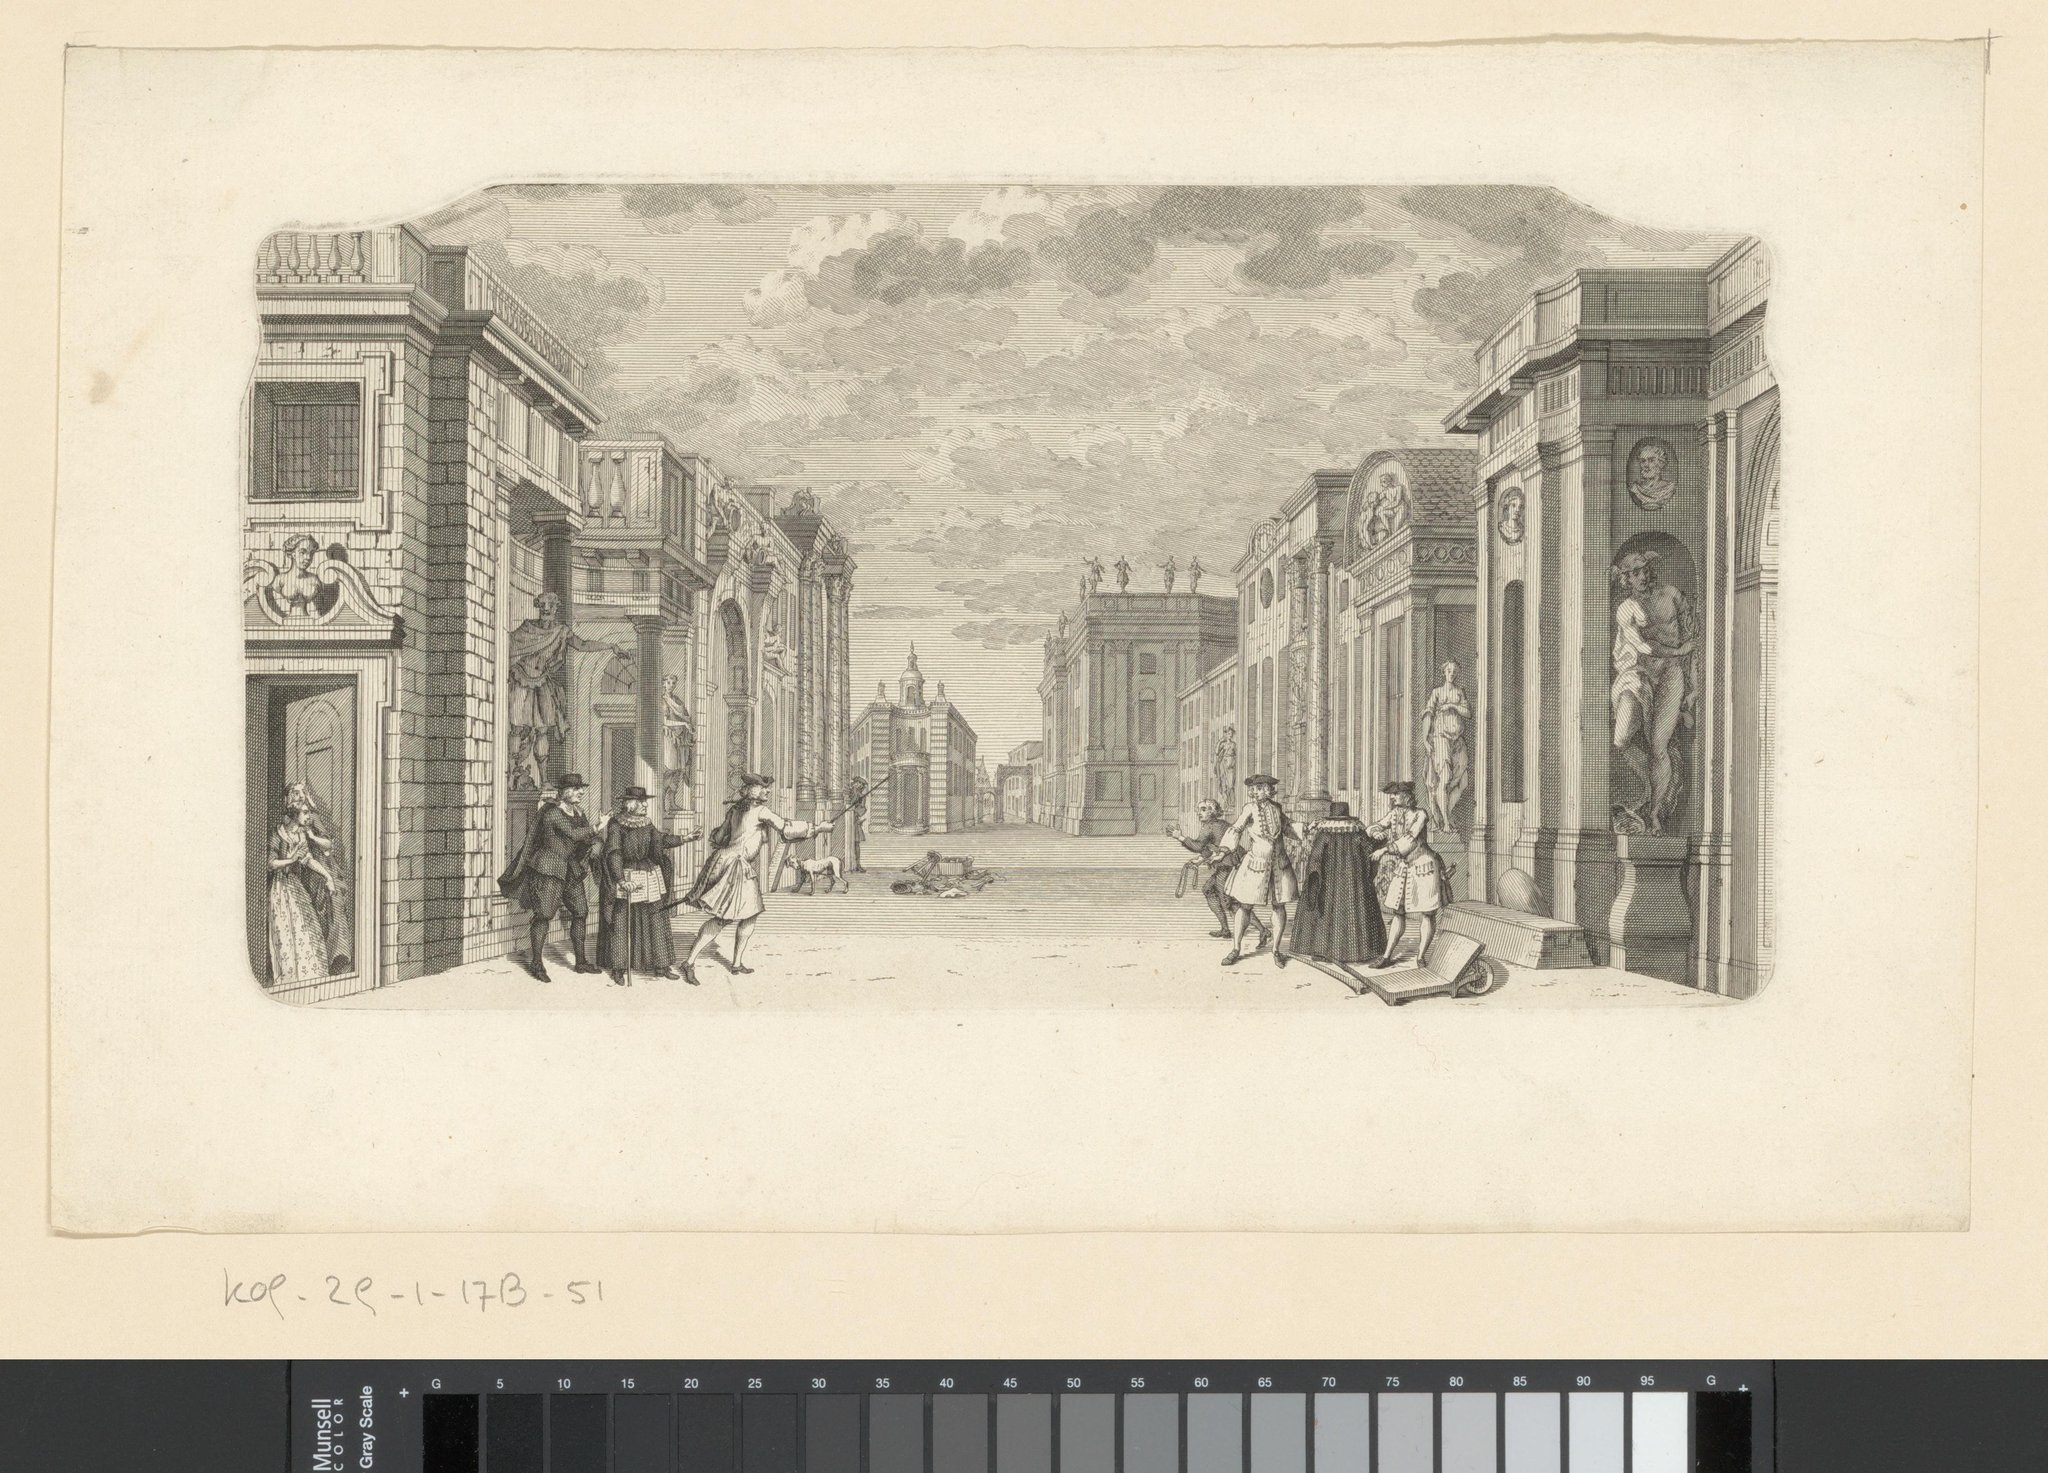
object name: print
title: Toneeldecors van de Amsterdamse Schouwburg, ca. 1760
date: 1736-1738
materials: paper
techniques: engraving, etching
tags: theatre, theatrical performance, stage design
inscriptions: stamp, collector's mark: Lugt 1641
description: Het coulissendecor De Italiaansche Straat met scène uit: De Gewaande Advocaat. Alleen het decor gedrukt van een aparte plaat, dus zonder het passe-partout. Onderdeel van een serie van twaalf toneeldecors van de Amsterdamse Schouwburg op de Keizersgracht. Onderwerpsrubrieken binnen de Atlas Zeden en Gewoonten: Schoone kunsten, Tooneel, Schouwburg op de Keizersgracht (1637 – 1772).